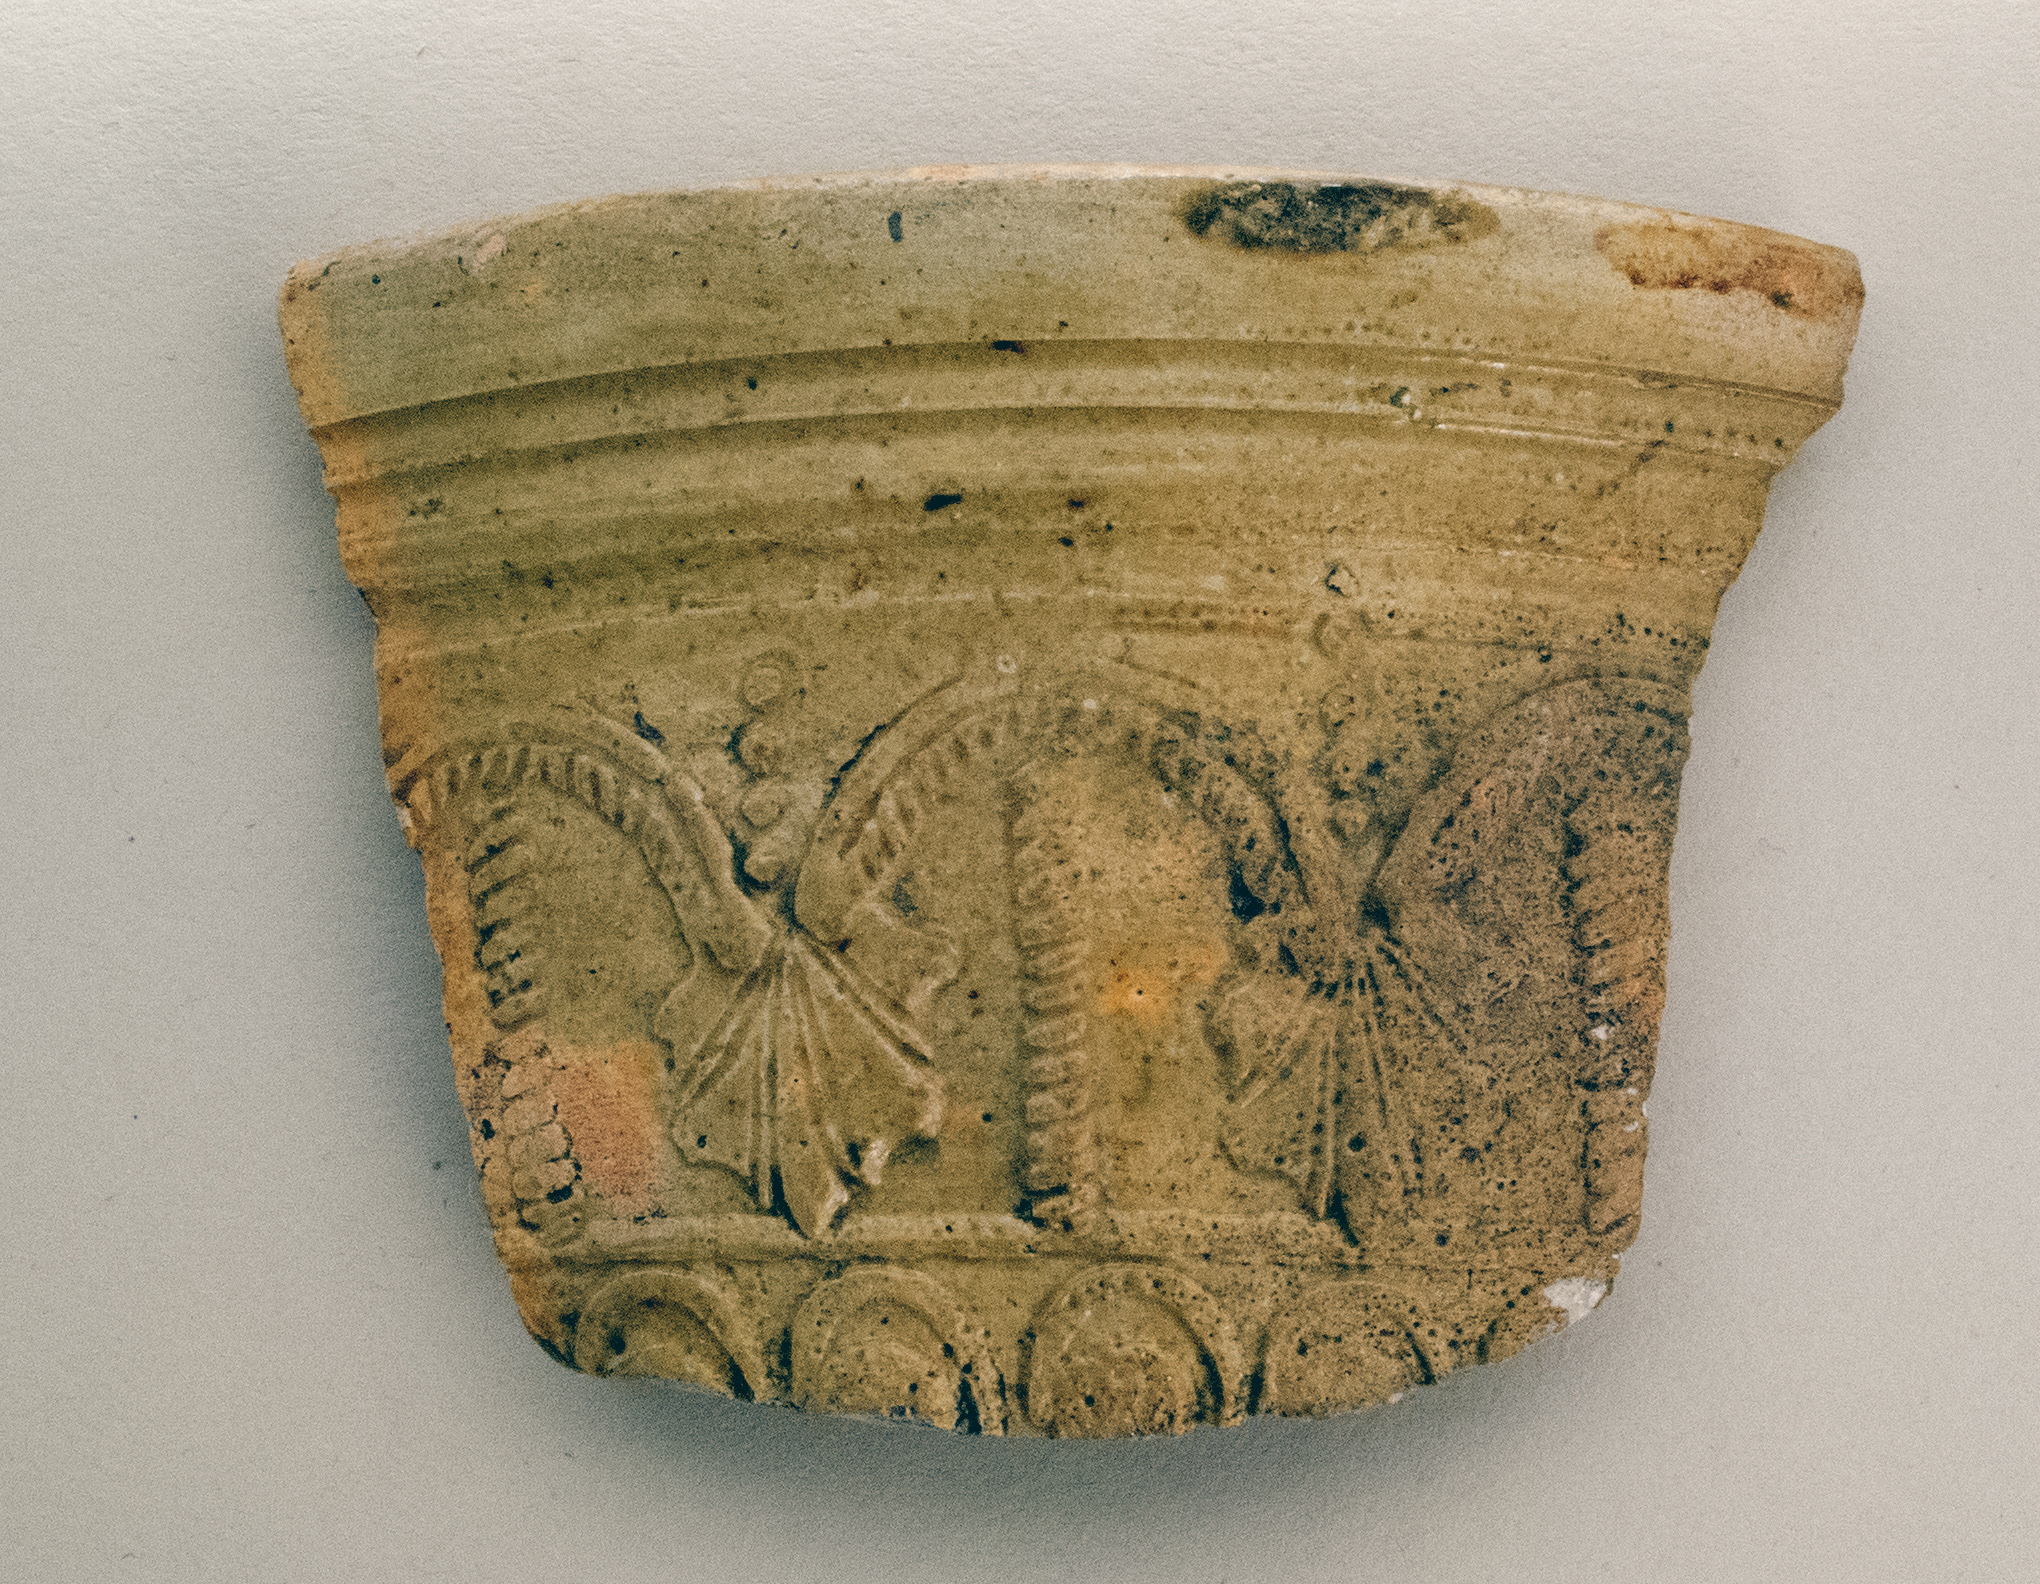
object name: vase fragment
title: Terracotta glazed bowl fragment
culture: roman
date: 20-70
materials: terracotta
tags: leaves